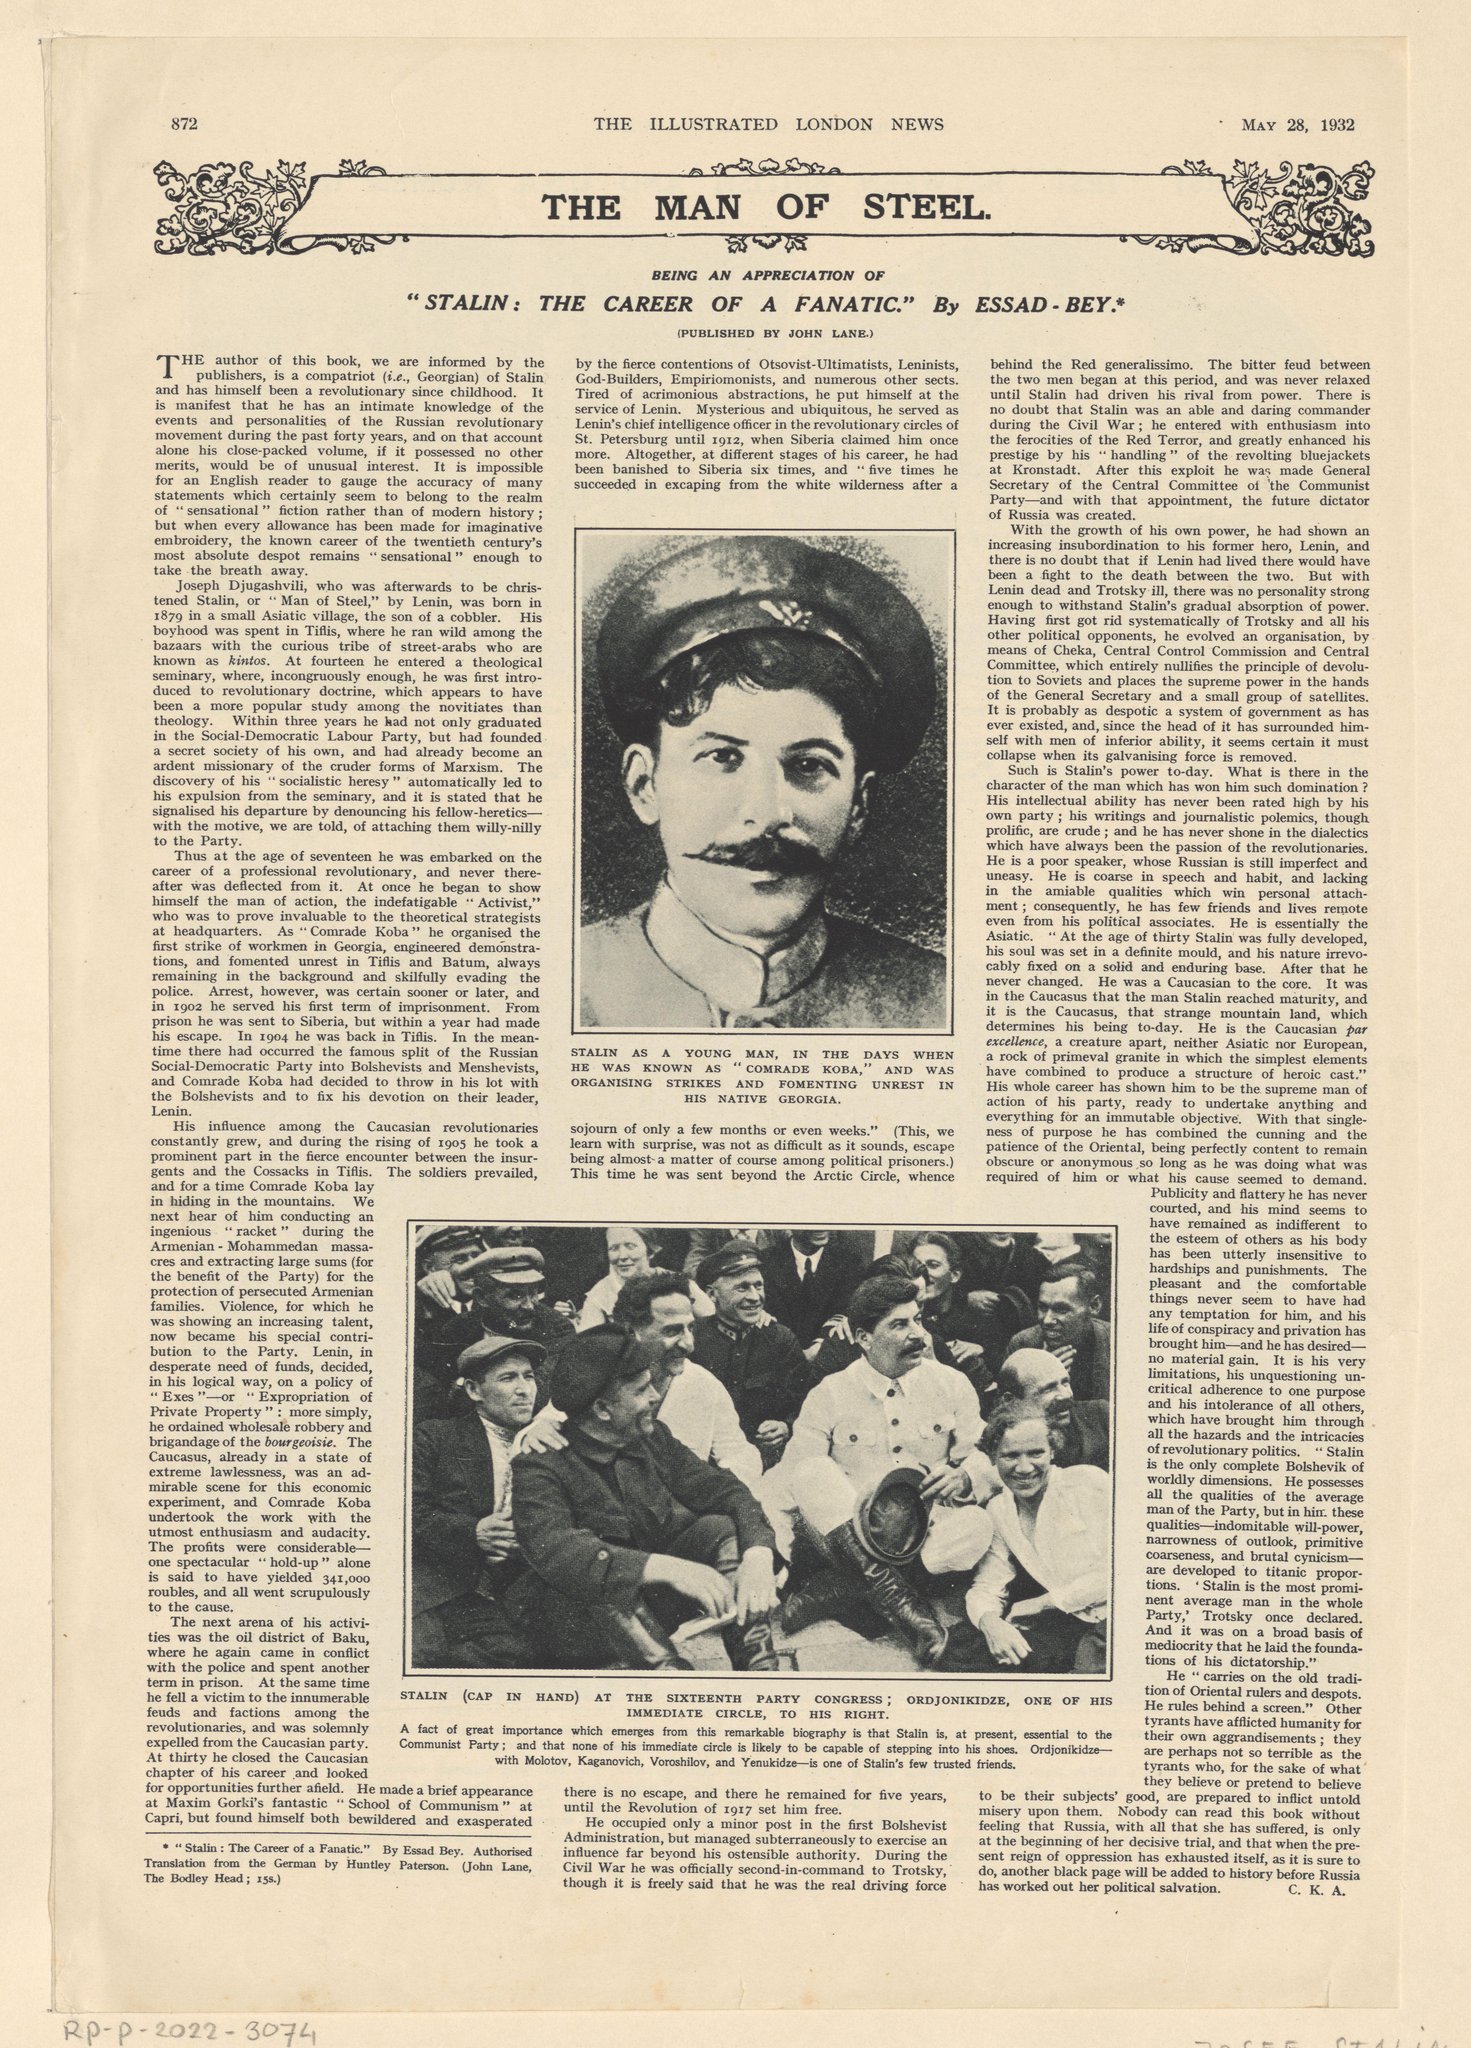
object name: photomechanical print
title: Portret van Joseph Stalin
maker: Anonymous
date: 1932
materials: paper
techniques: letterpress printing, rotogravure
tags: historical persons, politician, e.g. party leader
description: Fotomechanische afdruk uit: The Illustrated London News (1932), 28 mei 1932.